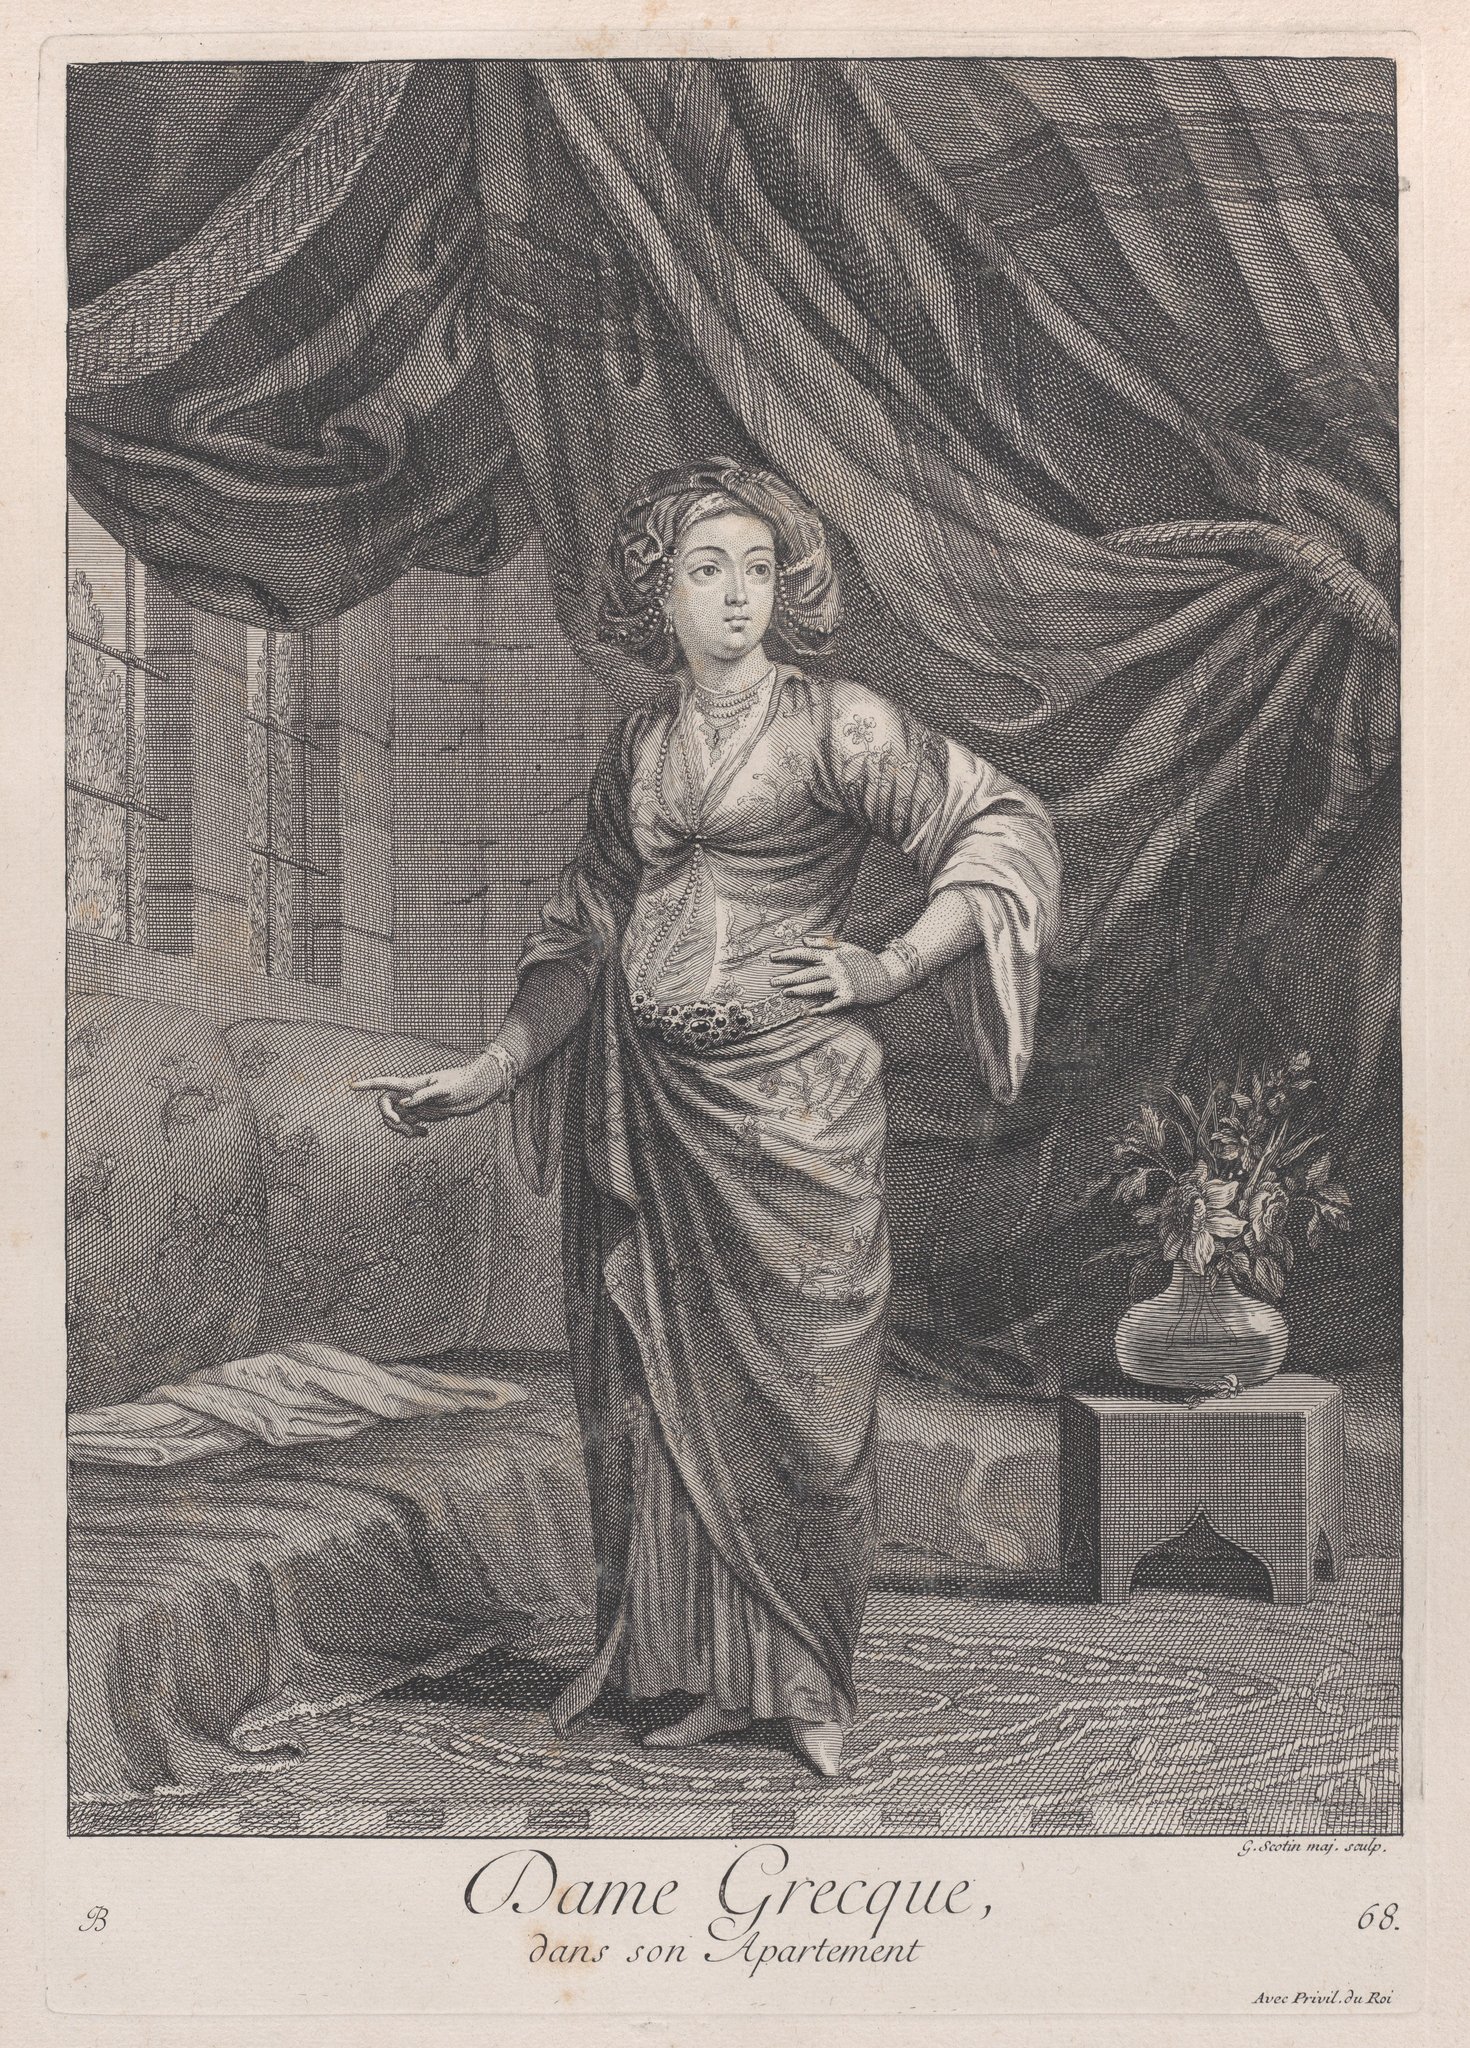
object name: print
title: Dame Grecque, dans son Apartement, plate 68 from "Recueil de cent estampes représentent differentes nations du Levant"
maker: jean baptiste vanmour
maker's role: artist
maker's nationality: french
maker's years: 1671-1737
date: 1714-1715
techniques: engraving, etching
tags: women